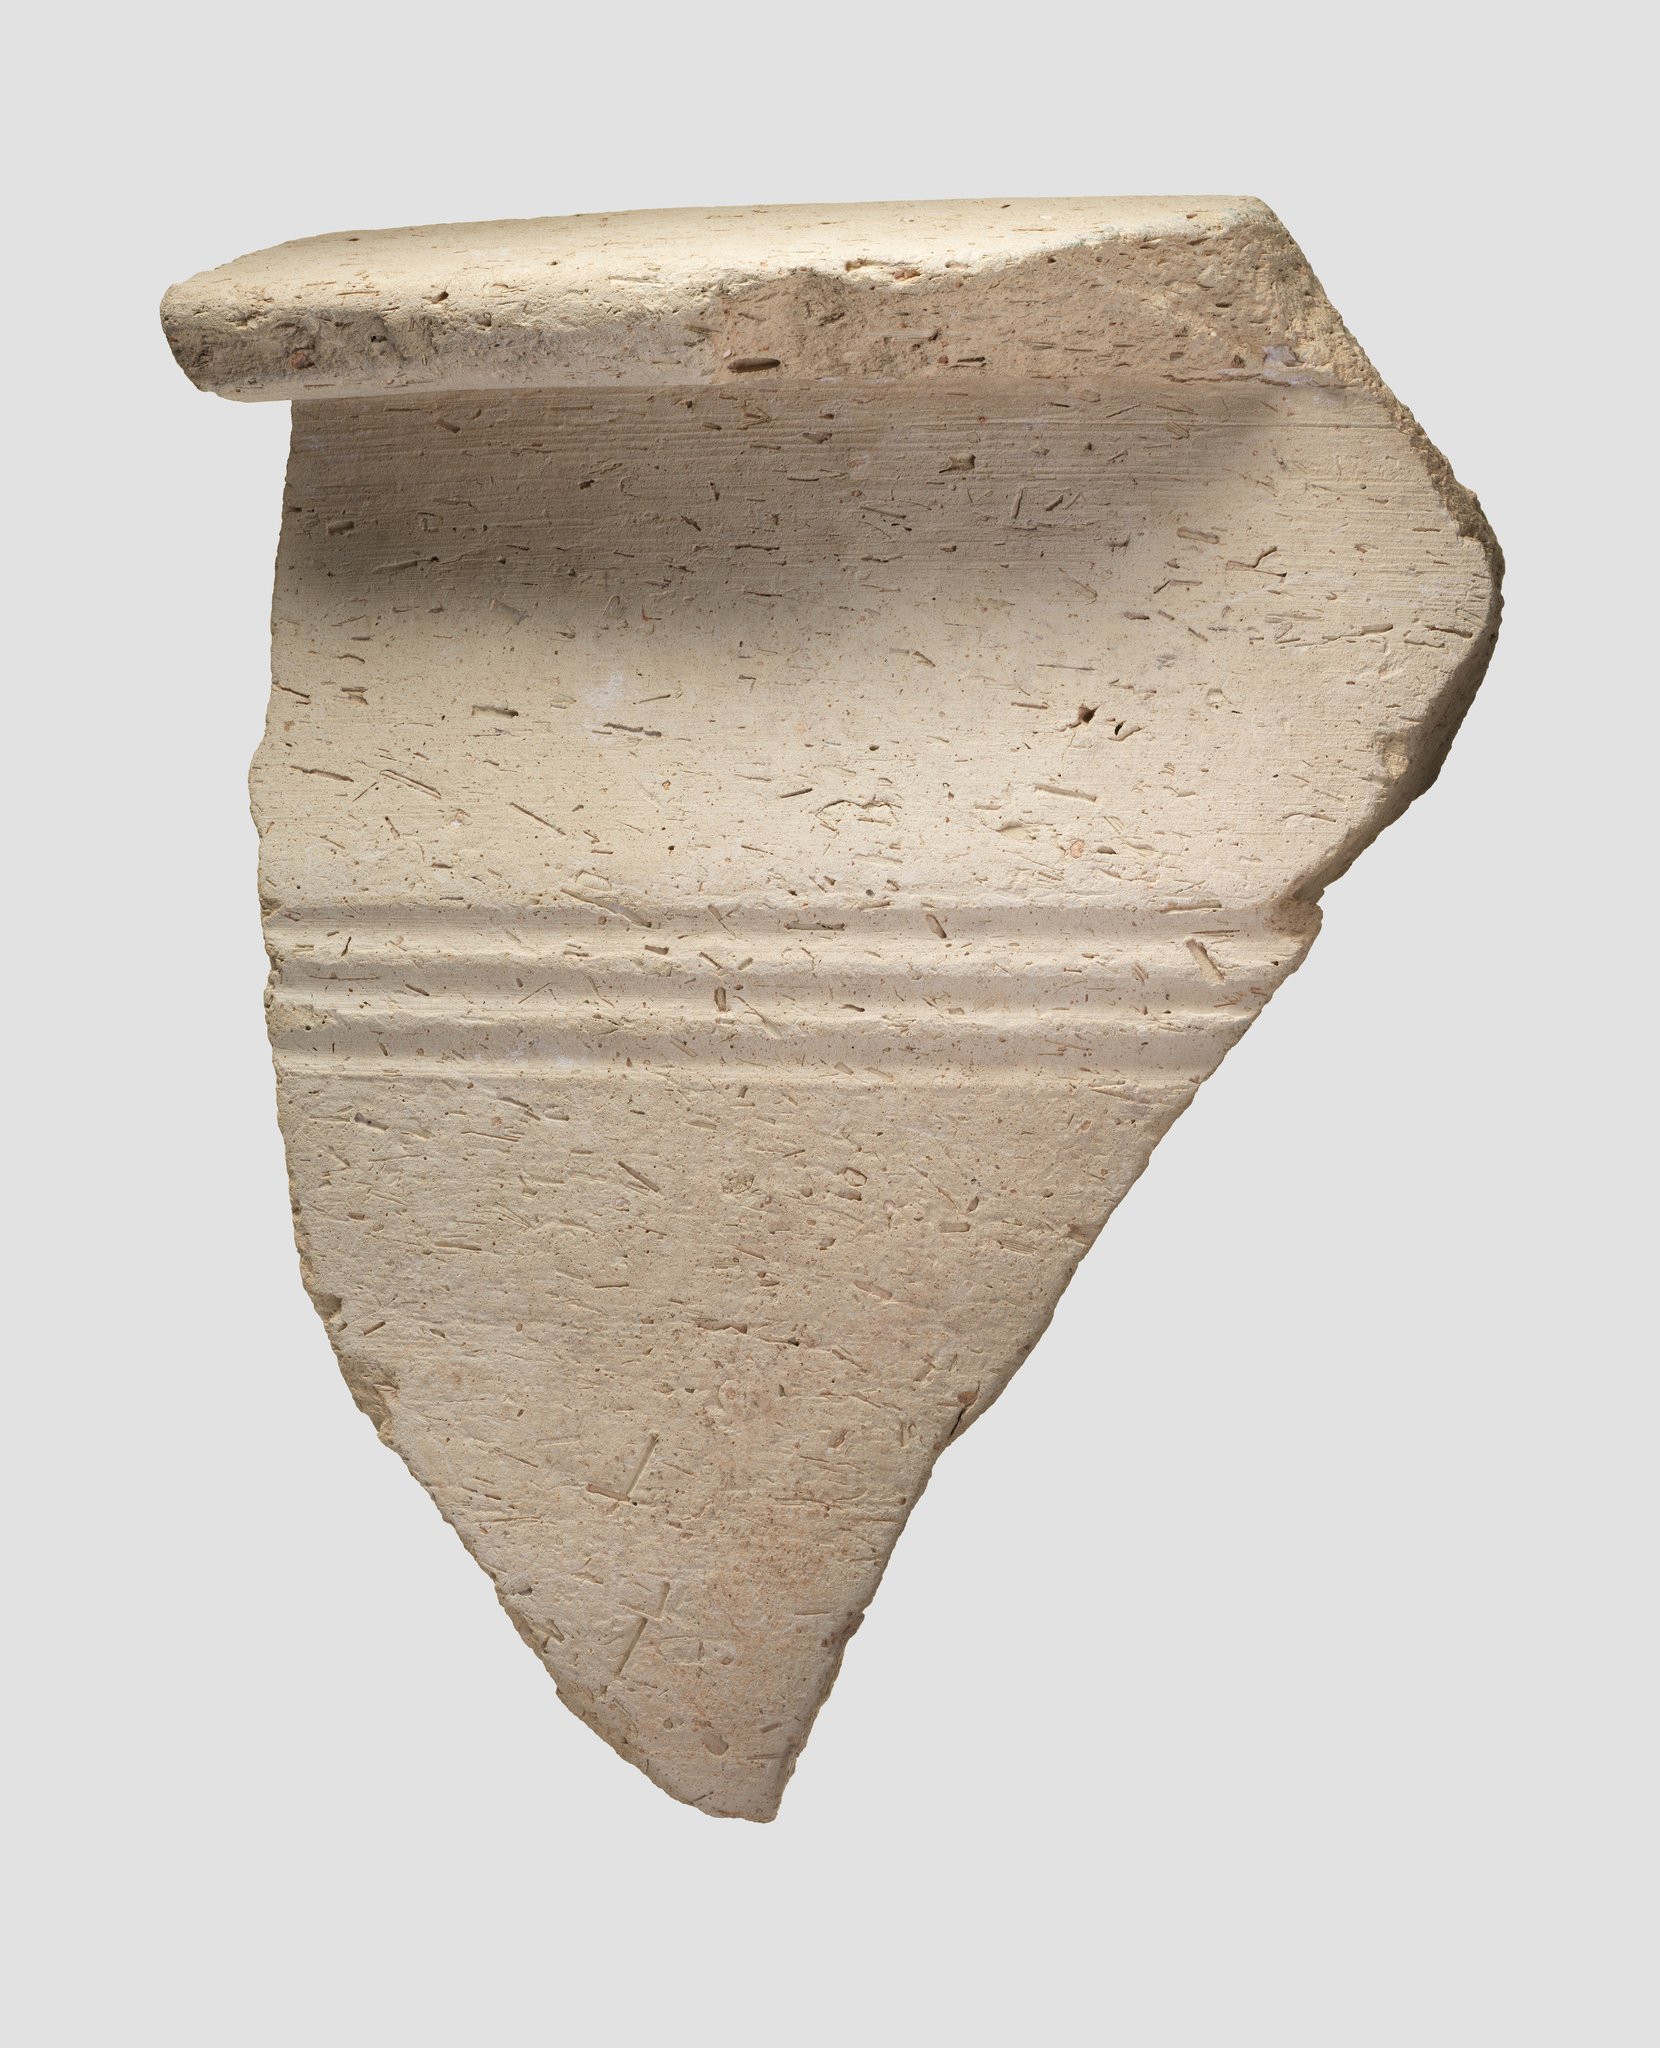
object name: sherd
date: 2000-1668 BCE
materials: ceramic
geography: mesopotamia